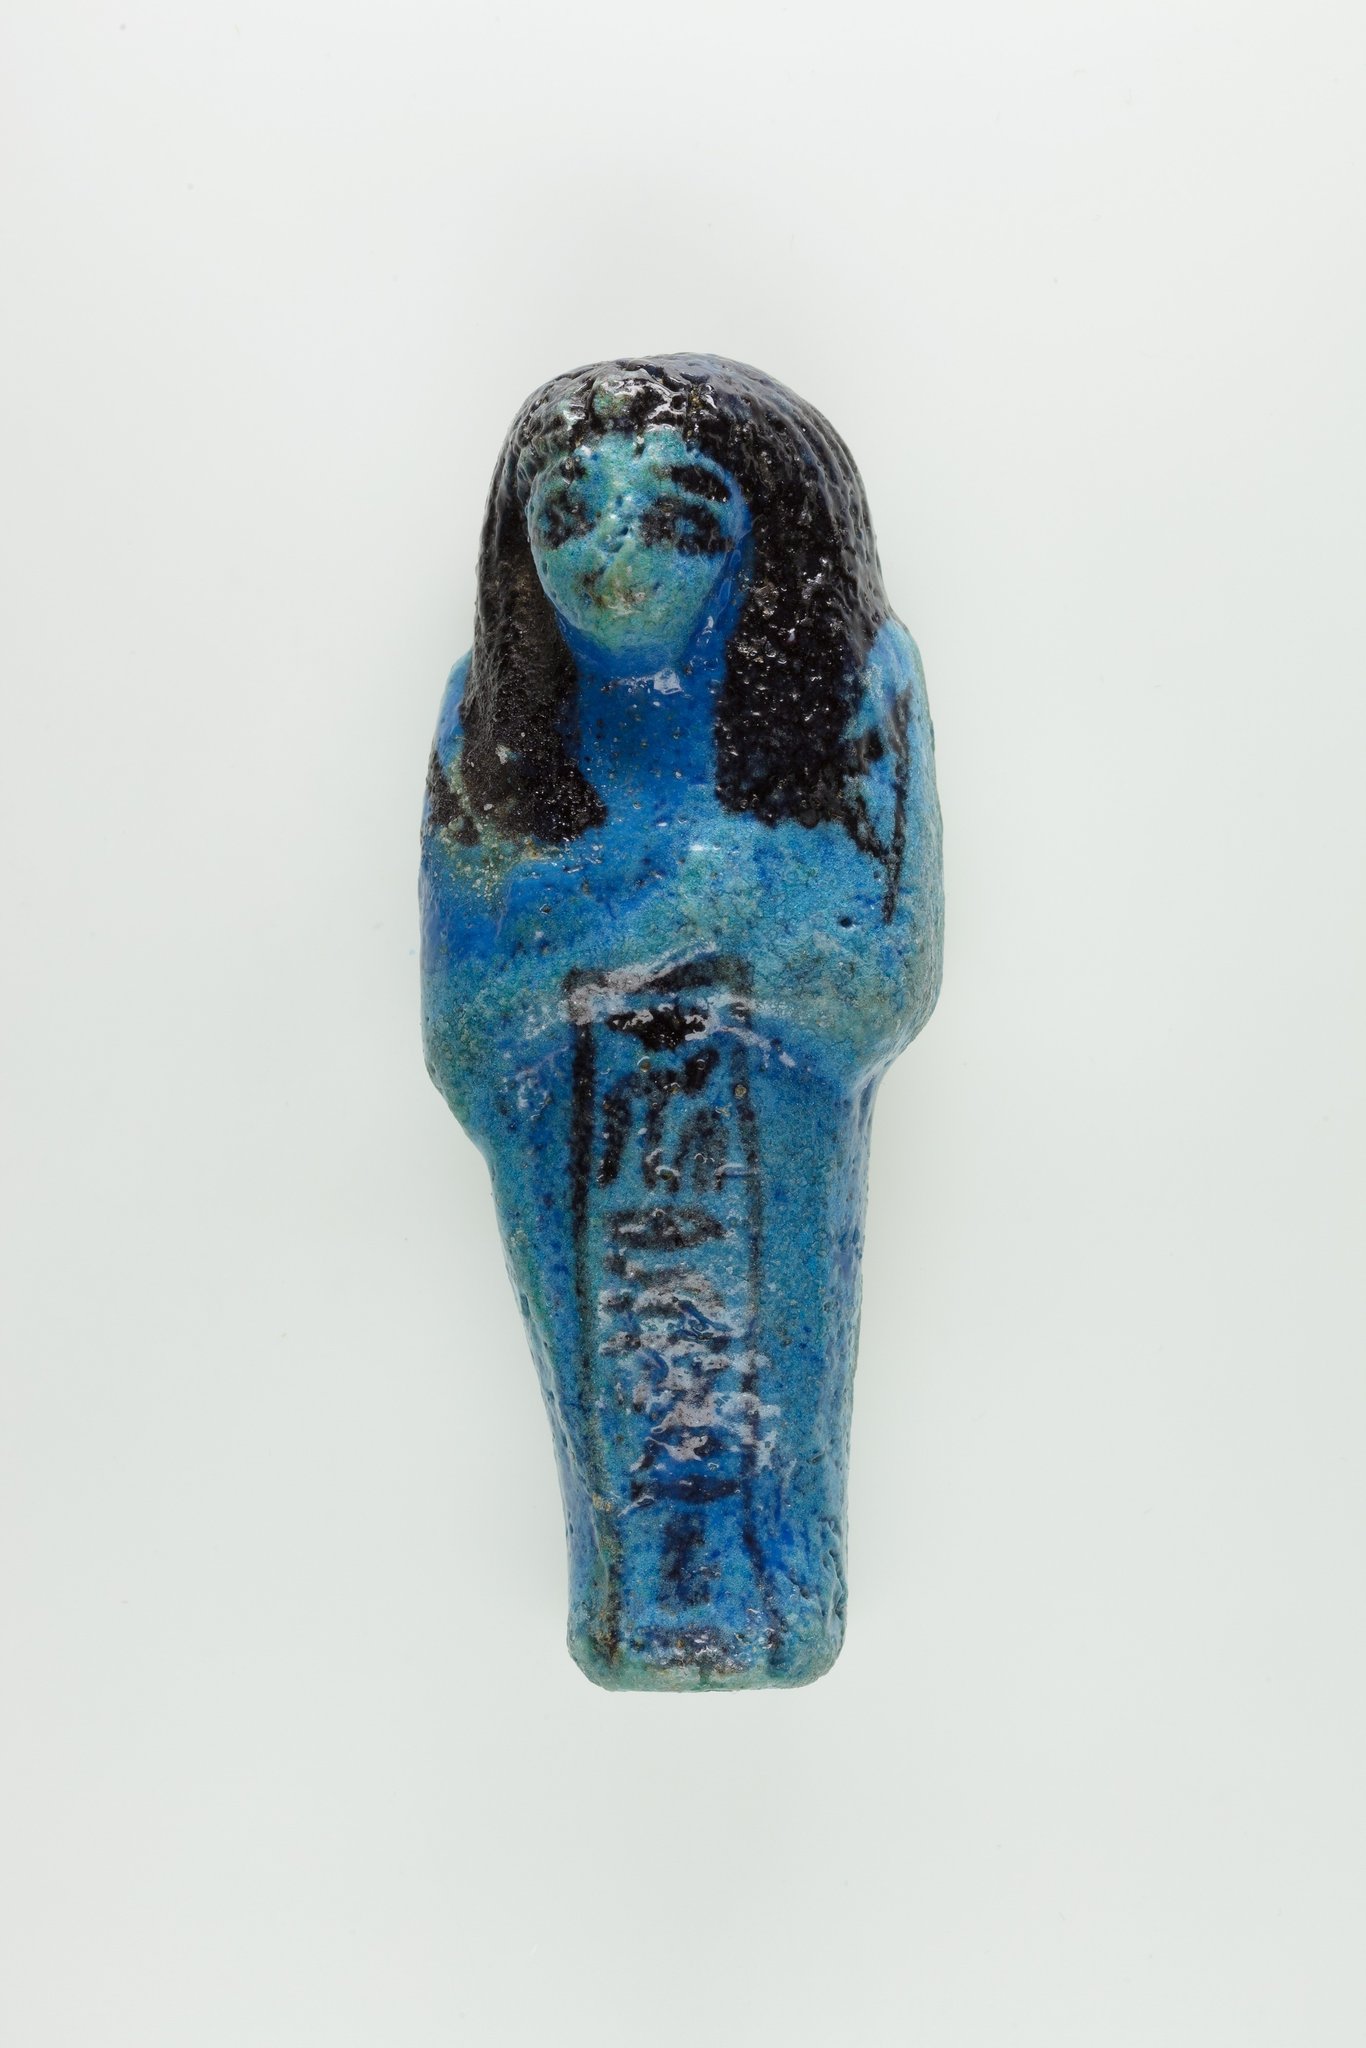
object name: shabti, worker, nauny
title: Worker Shabti of Nauny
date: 1050 BCE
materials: faience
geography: egypt